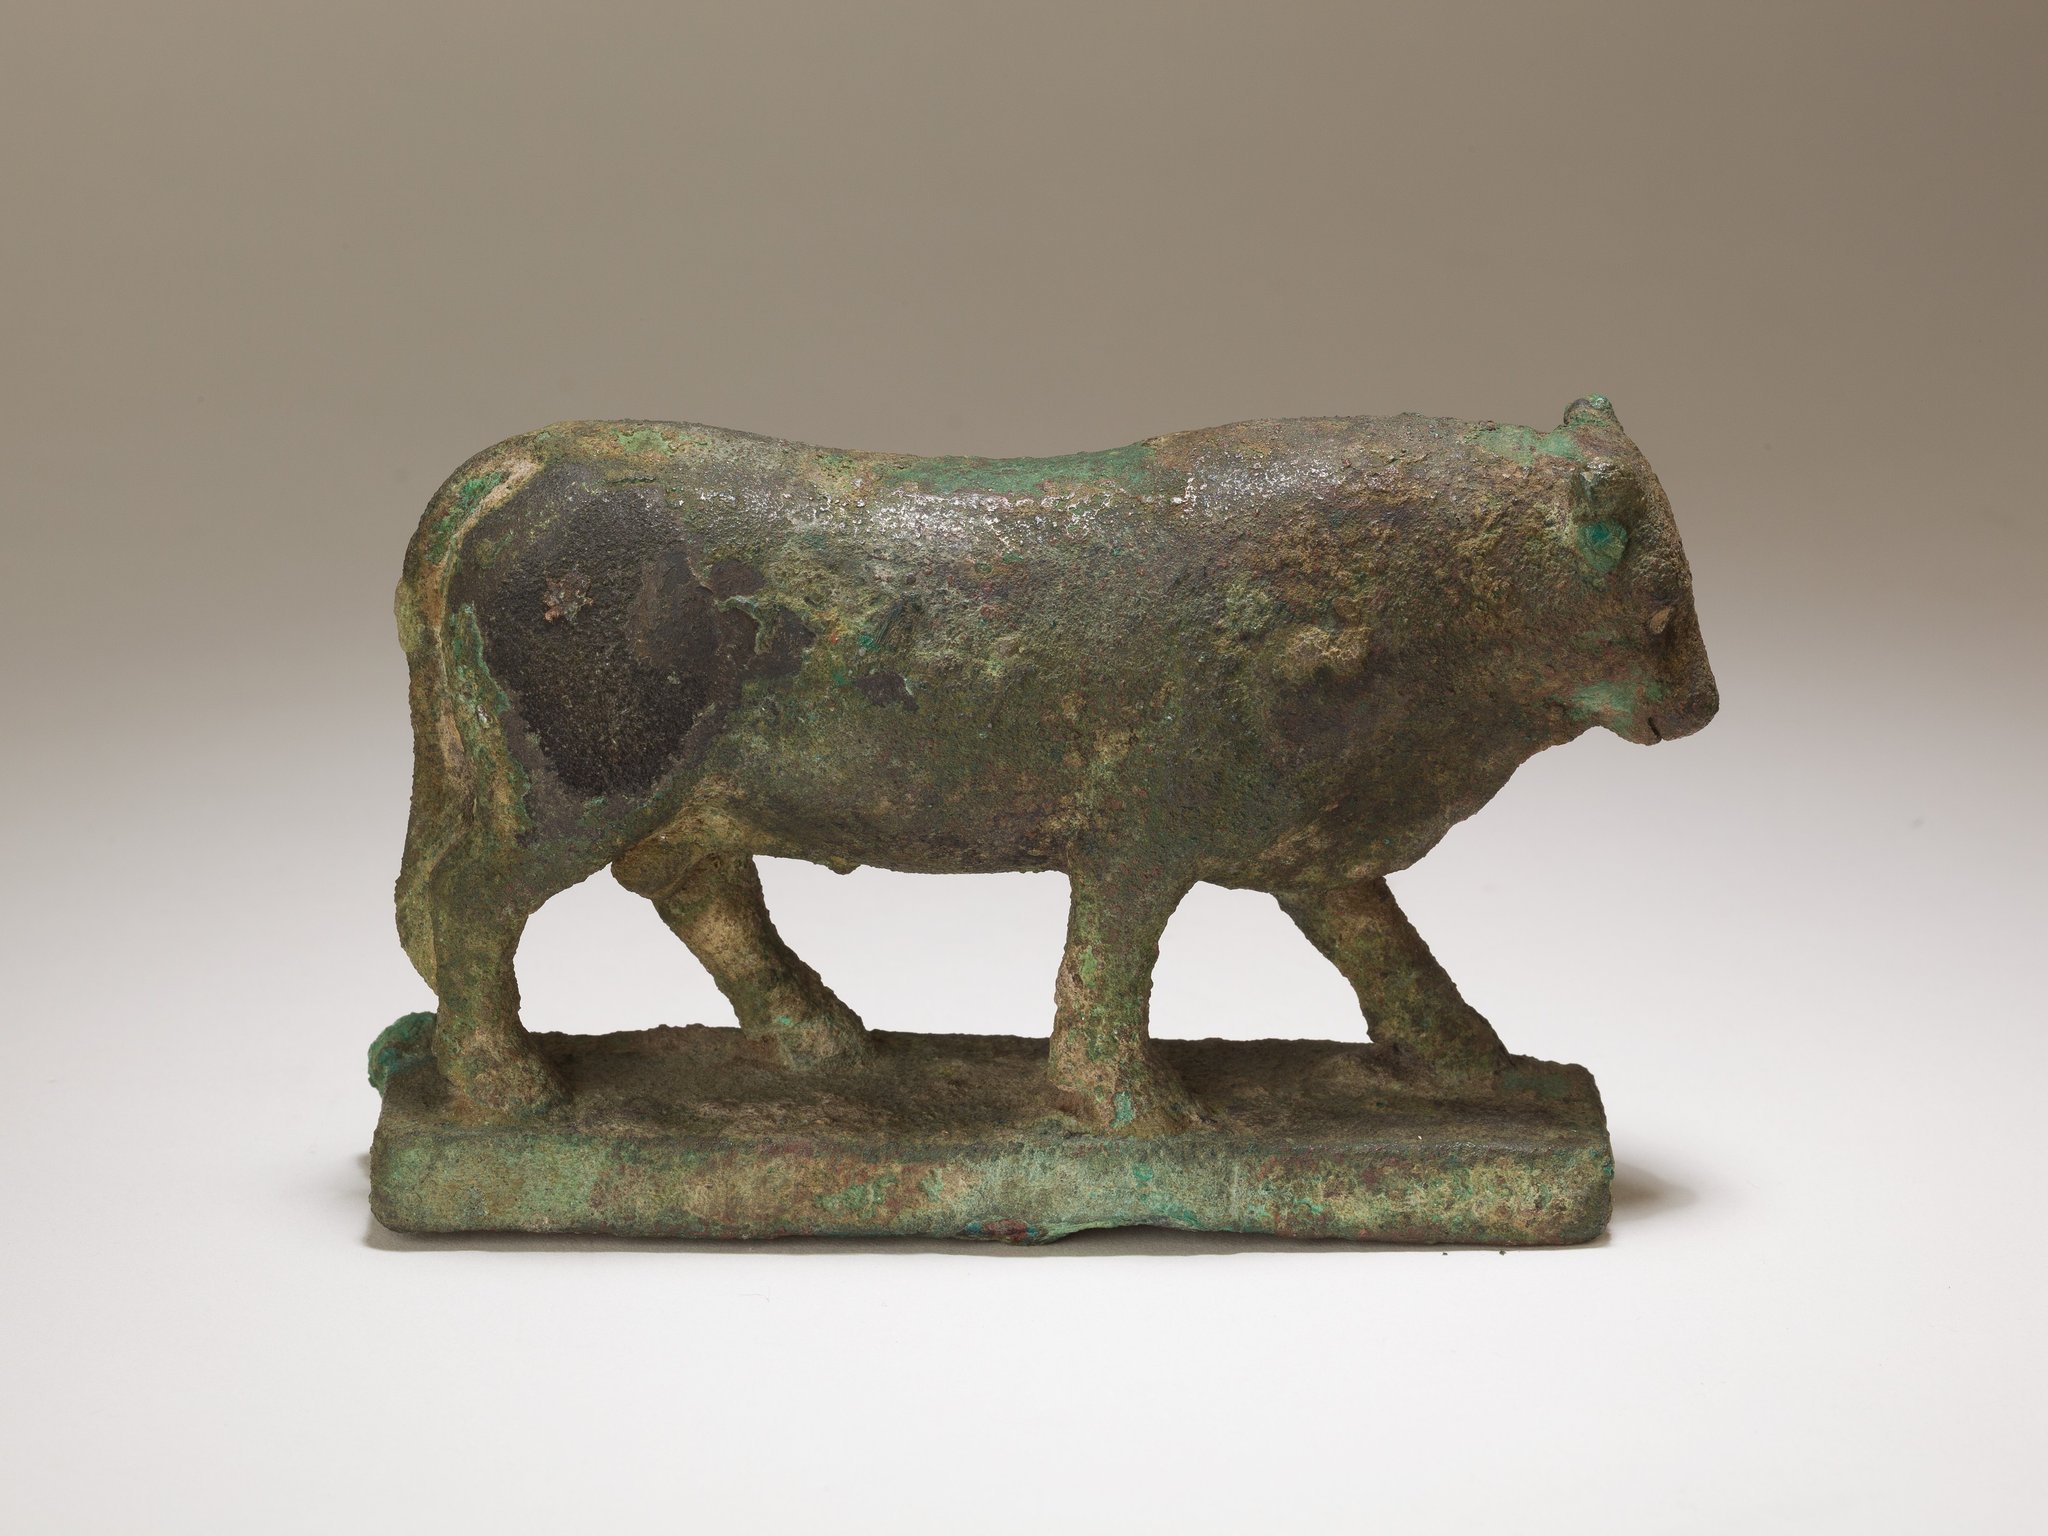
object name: figurine, bull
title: Bull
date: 664-630 BCE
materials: metal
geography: egypt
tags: bulls